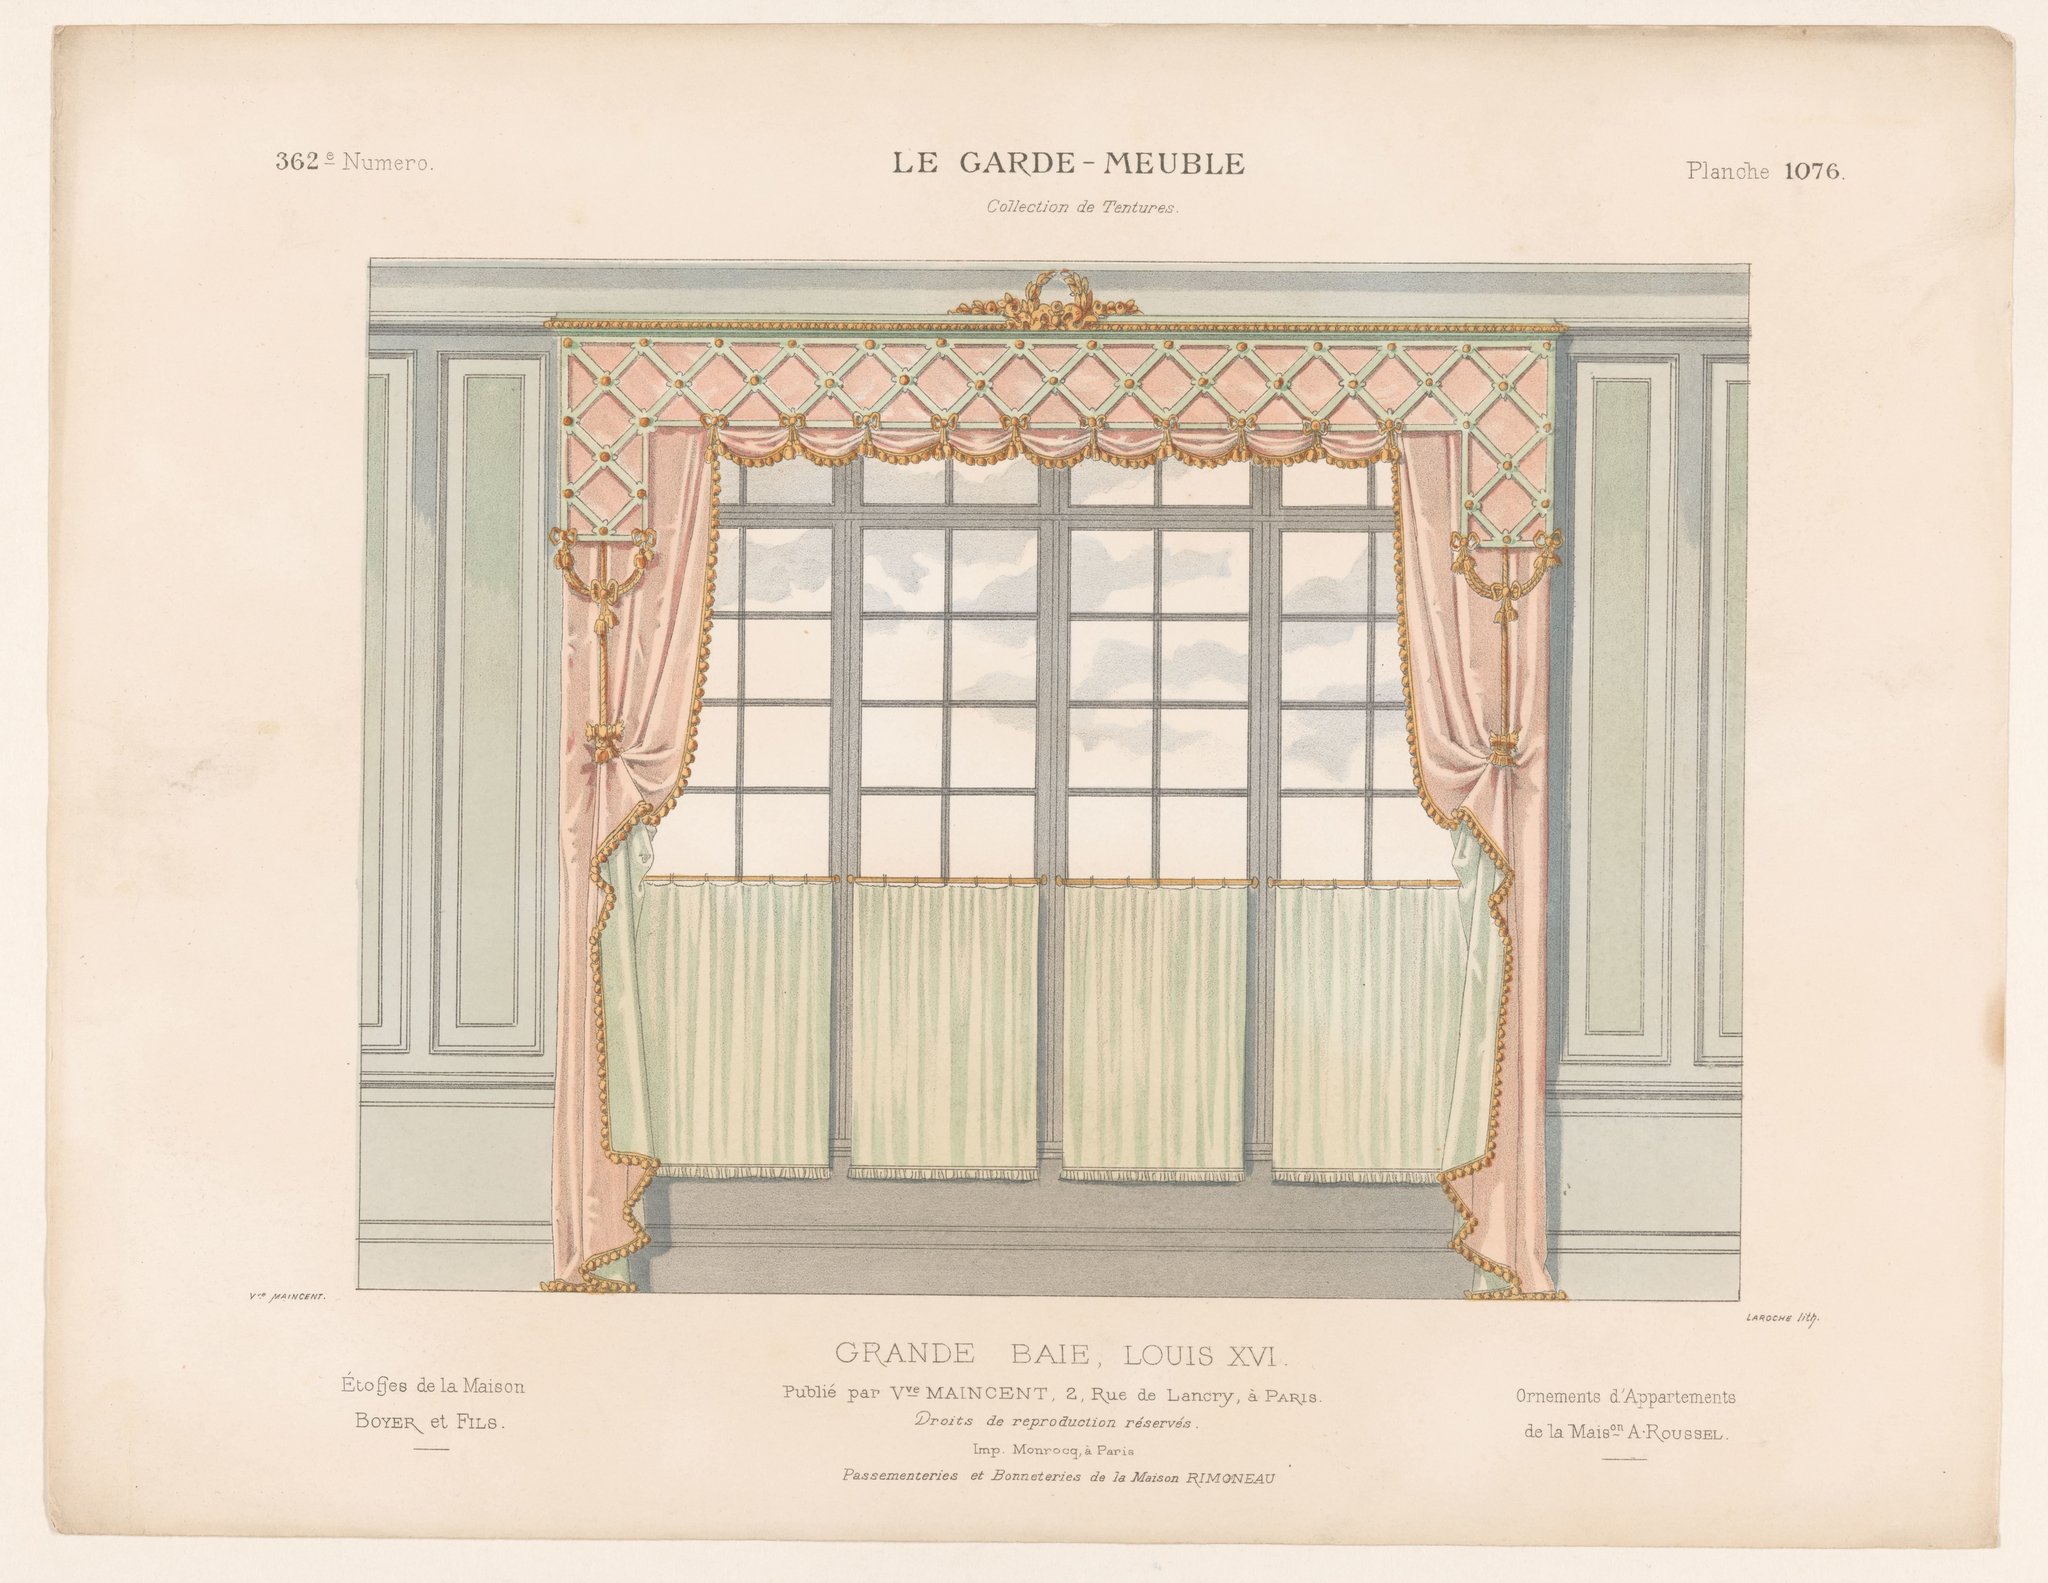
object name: print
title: Grande Baie, Louis XVI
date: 1895-1910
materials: paper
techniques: hand coloring, lithograph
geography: paris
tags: window, hangings and drapery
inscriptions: : ‘Droits de reproduction réservés.’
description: Grote raampartij met gedrapeerde gordijnen in de Lodewijk XVI-stijl. Prent uit 362e Livraison.